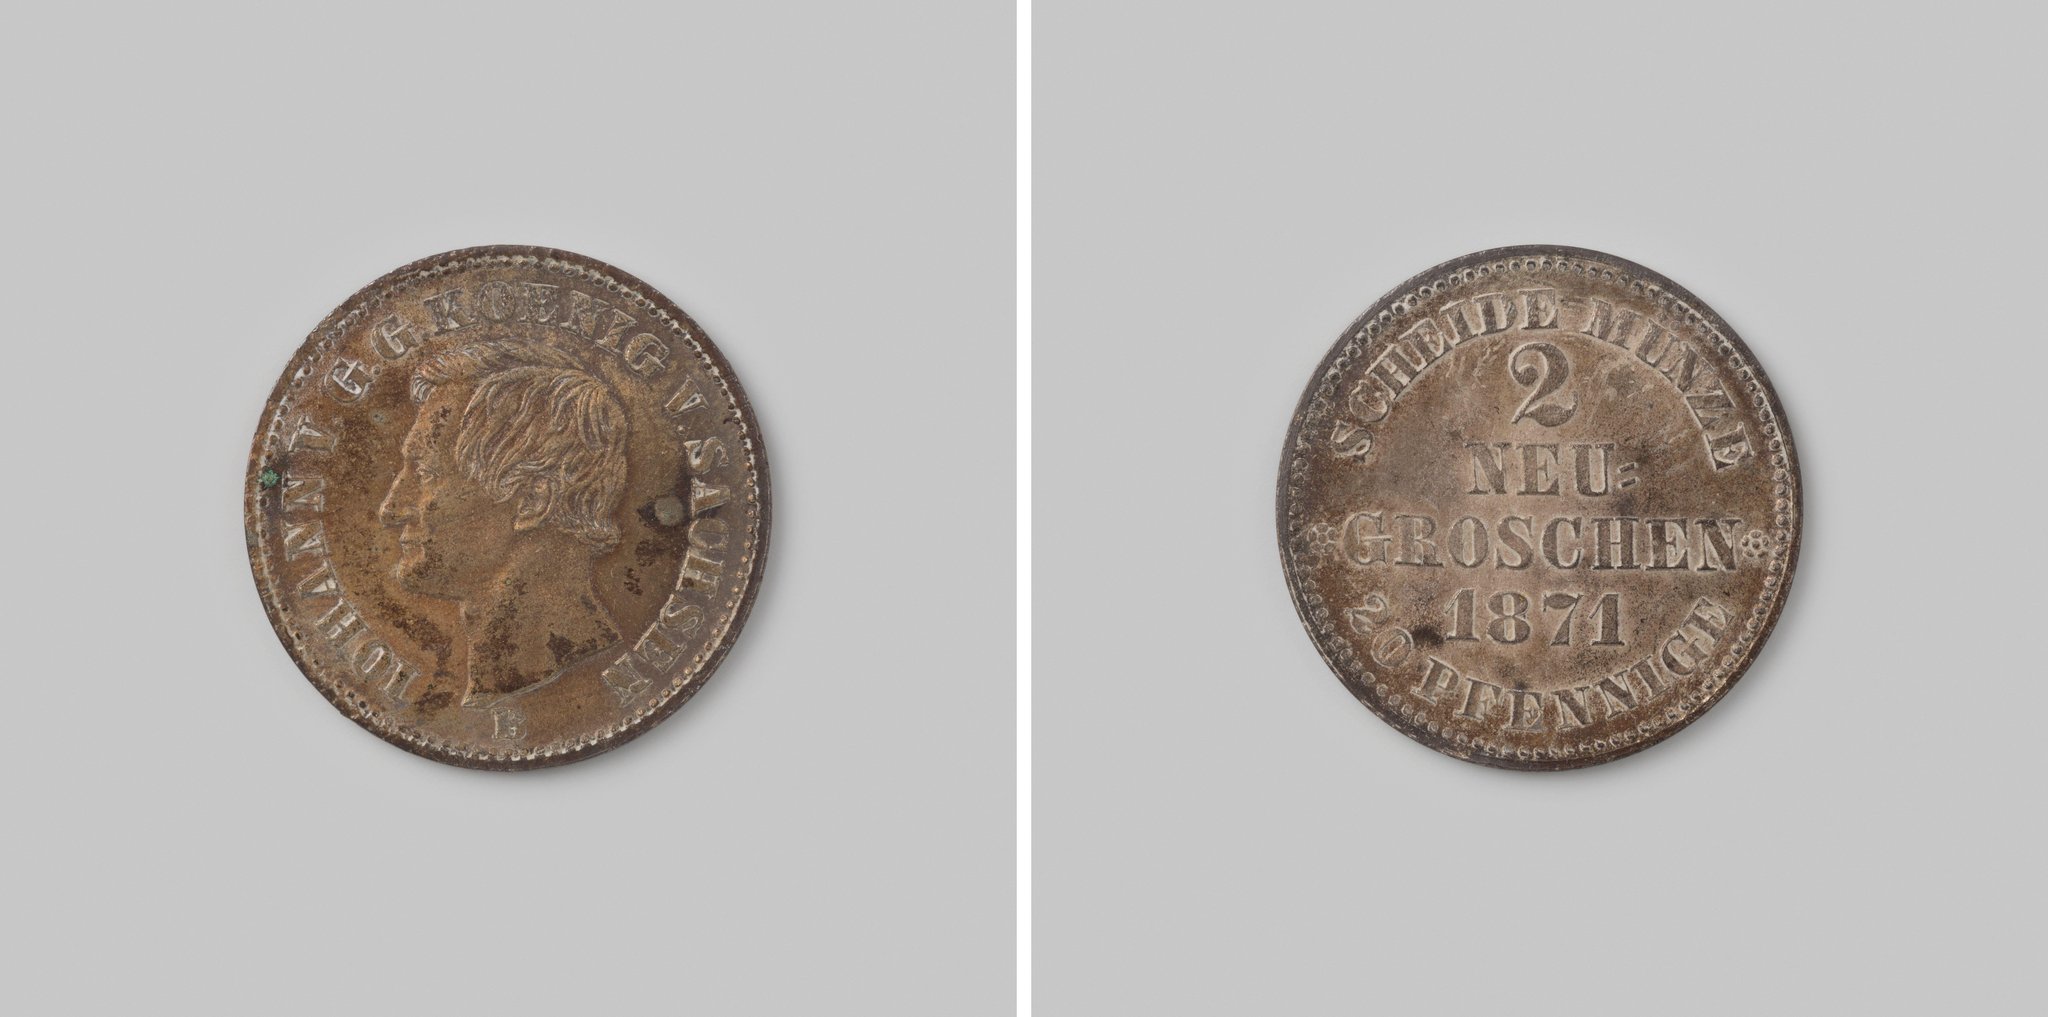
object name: coin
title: Koninkrijk Saksen, Johann, 2 neugroschen,1871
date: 1871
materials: silver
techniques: striking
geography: dresden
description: Zilveren munt. Voorzijde: hoofd van de koning naar links. Onder hoofd letter B. Keerzijde: waarde-aanduiding in drie regels, waaronder jaartal. Kartelrand.